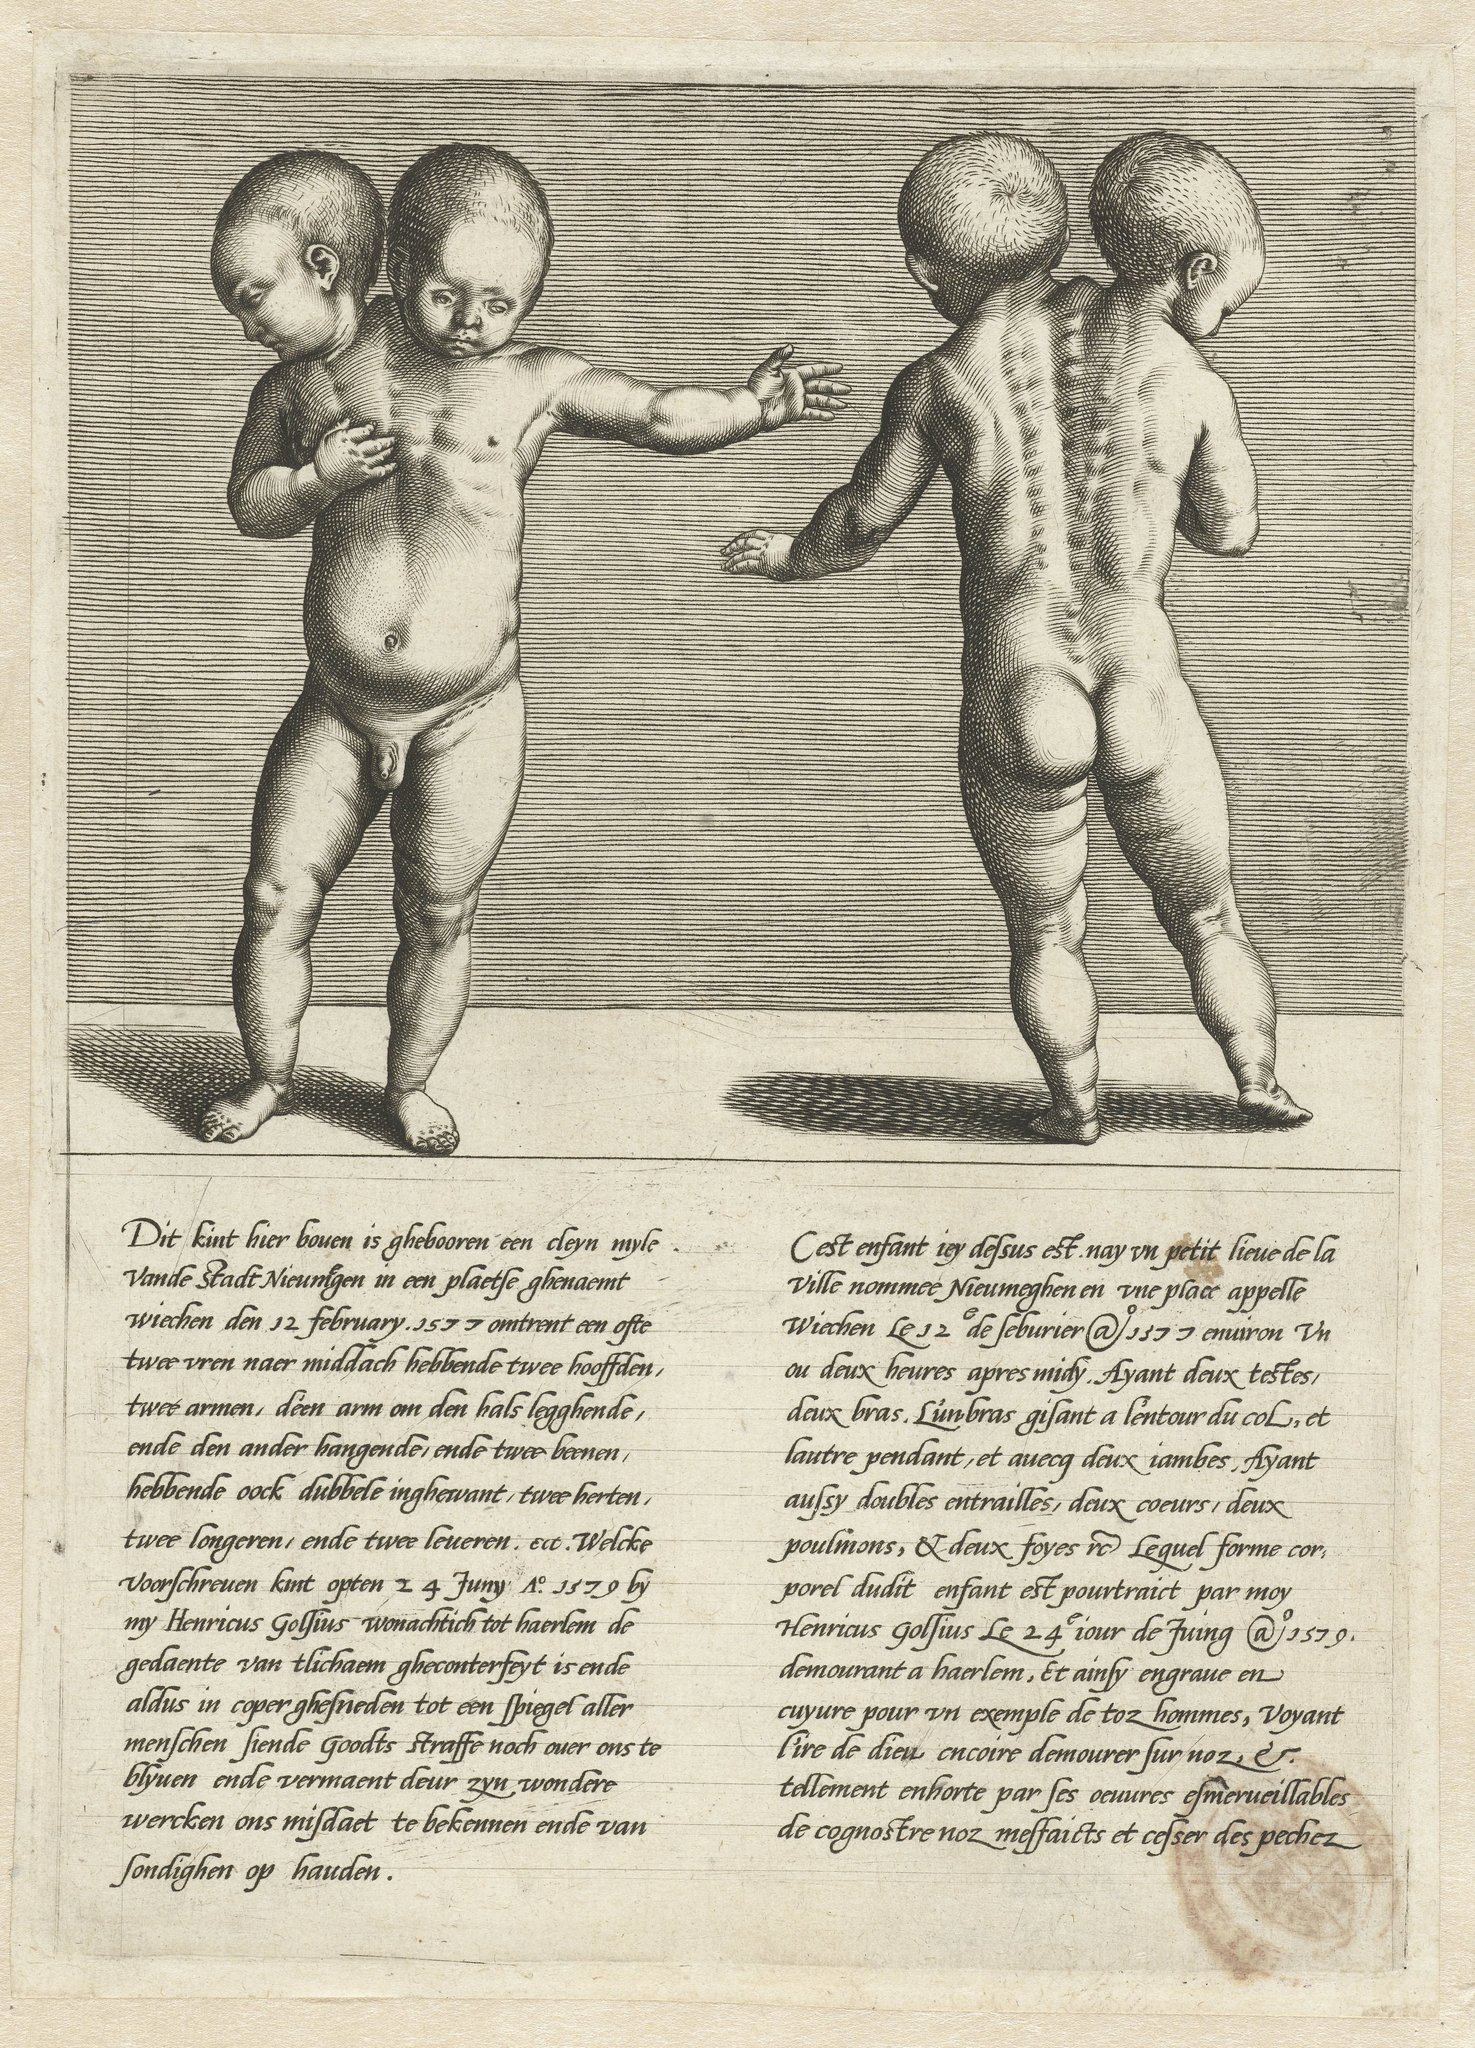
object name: print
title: Nieuwsblad over een vergroeide tweeling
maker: hendrick goltzius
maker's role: draughtsman, painter, print maker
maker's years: 1558-1617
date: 1579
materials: paper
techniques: engraving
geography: haarlem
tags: siamese twins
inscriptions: collector's mark: Lugt 240, signature and date: ‘"....24 Juny Ao. 1579 by my Henricus Golsius woonachtich tot haerlam de gedaente van tlichaem gheconterfeyt is ende alsus in coper ghesneden...."’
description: Figuur met twee hoofden en ruggengraten, twee armen en twee benen, in vooraanzicht en op de rug gezien. Goltzius voorzag deze prent van twee lange teksten met meer informatie over deze aan elkaar vergroeide tweeling, zowel in het Nederlands als in het Frans.